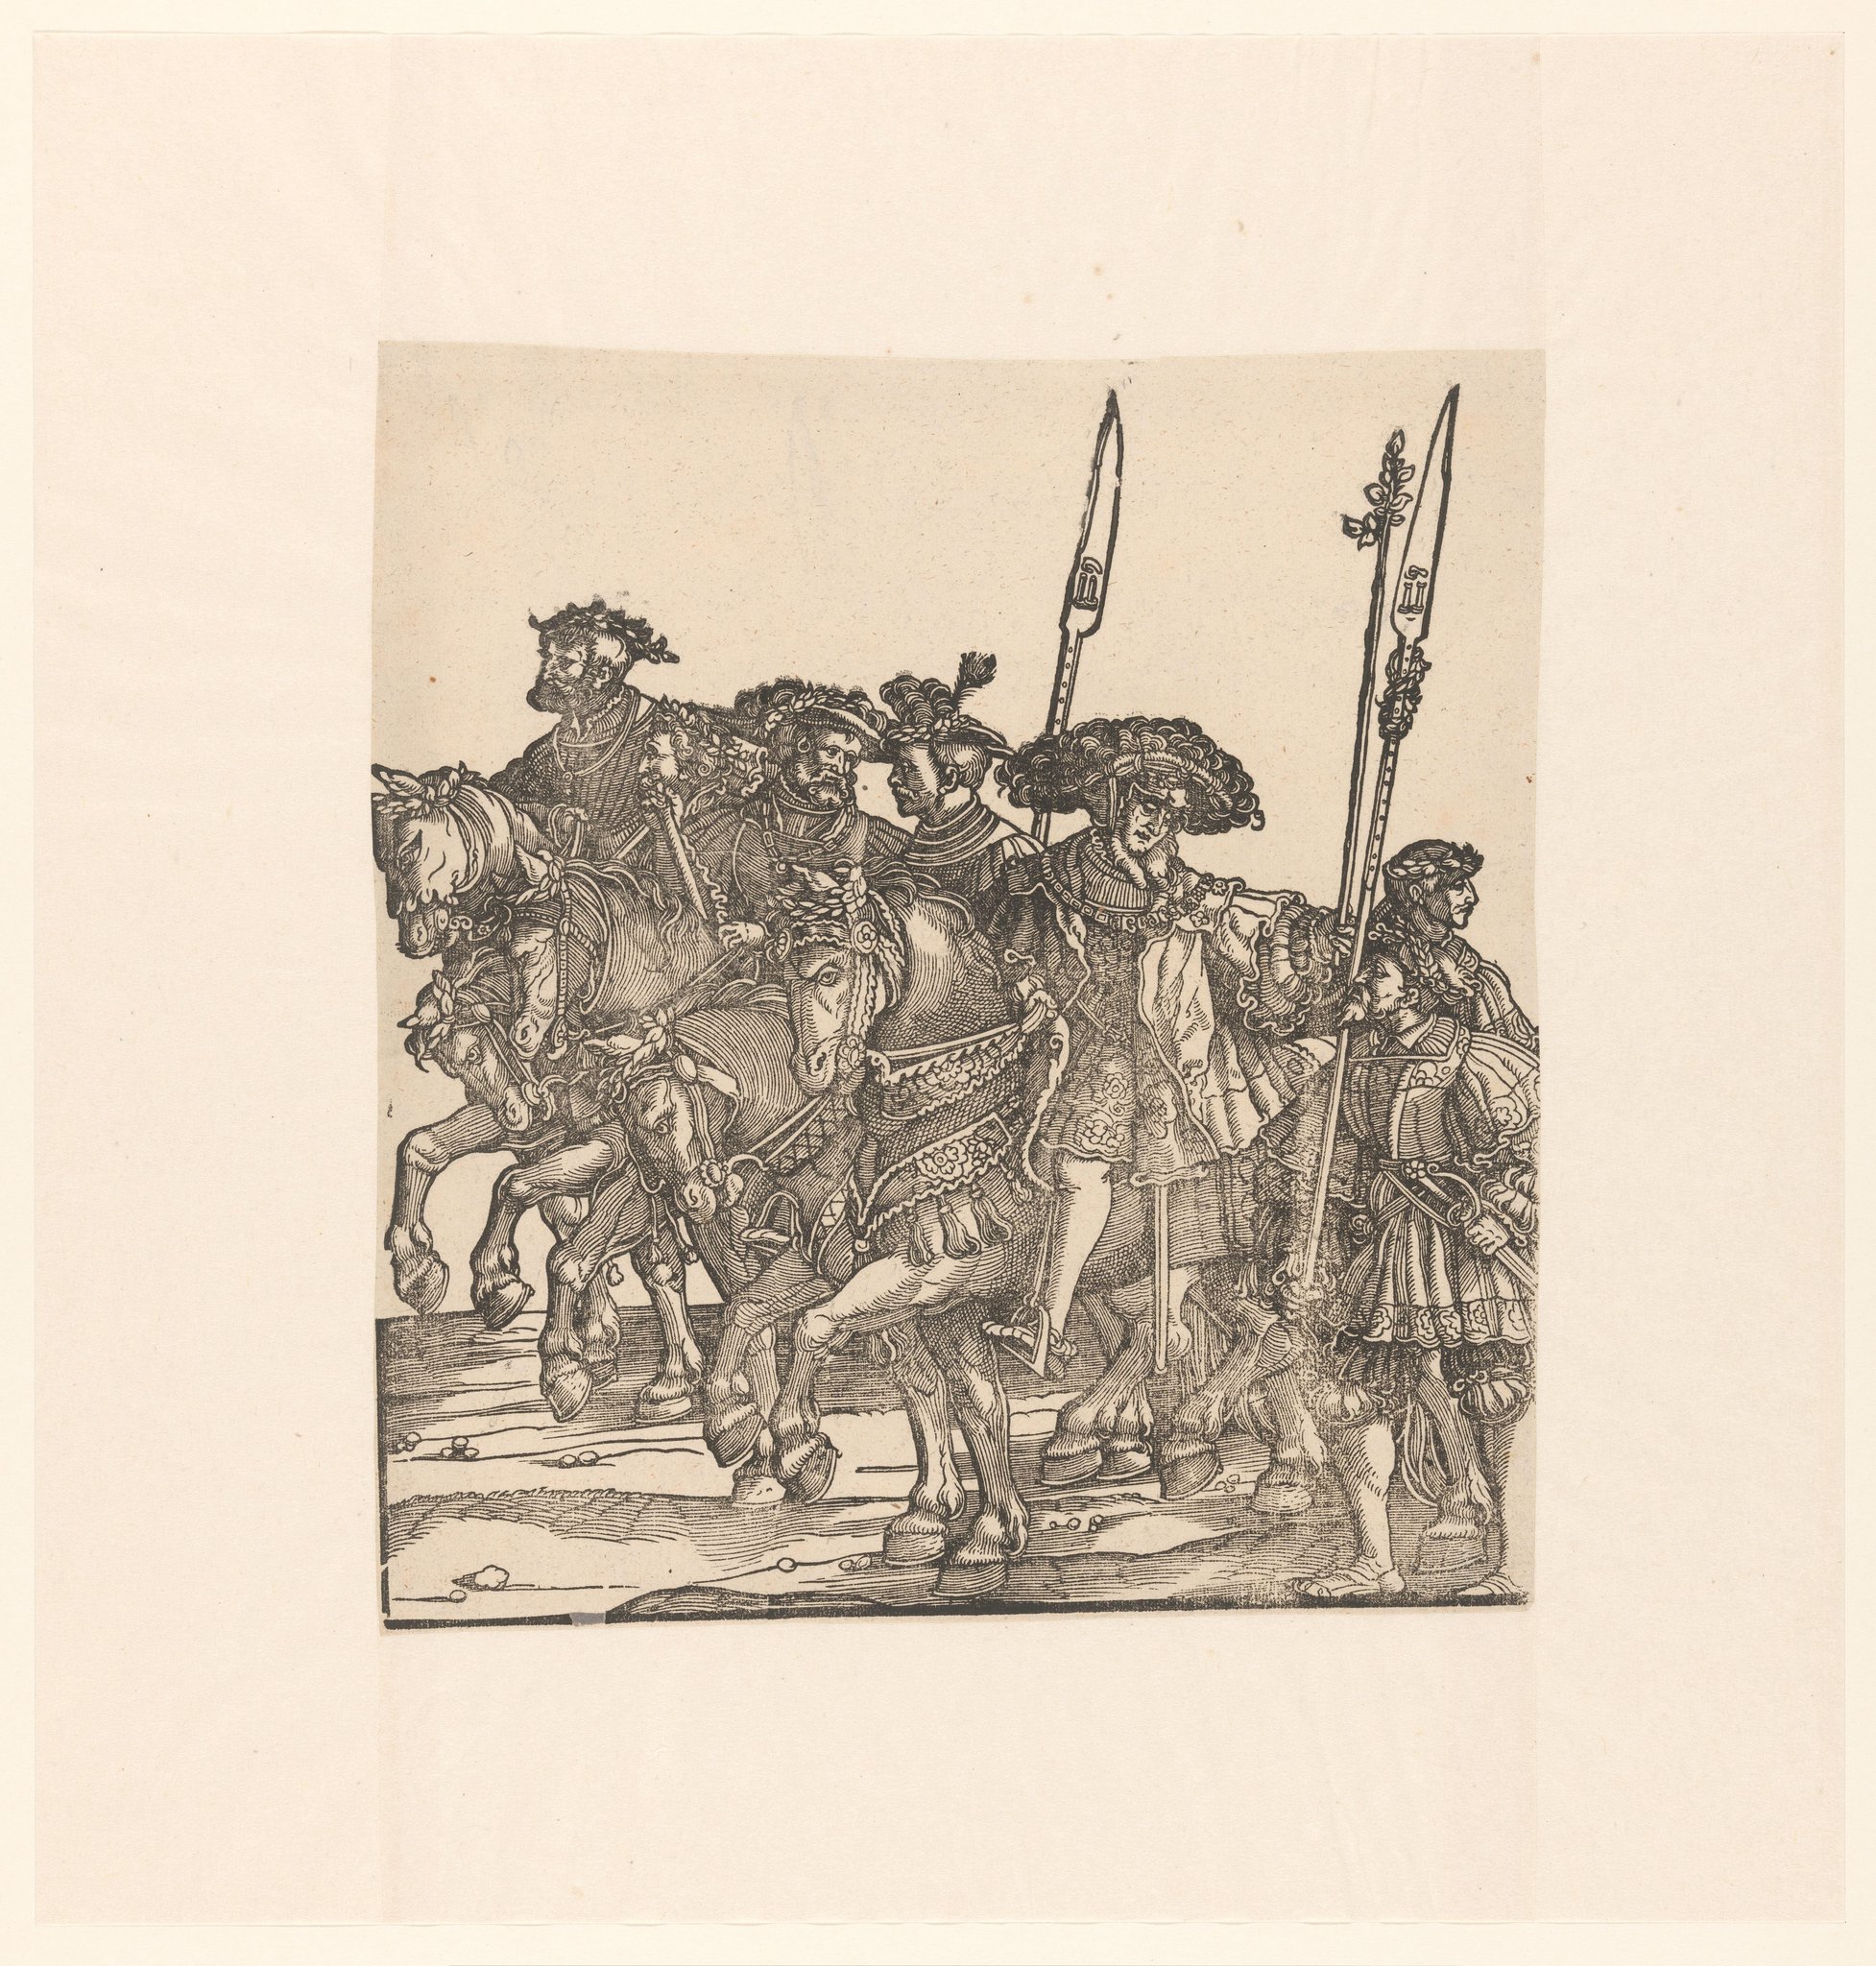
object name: print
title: Ruiters en voetknechten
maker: hans schäufelein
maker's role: print maker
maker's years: 1480-1540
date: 1537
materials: paper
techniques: woodcut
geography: germany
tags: charles v (holy roman emperor and king of spain), chariot, triumphal car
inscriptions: collector's mark: Lugt 2228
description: Serie van 9 houtsneden van de triomfwagen van keizer Karel V die aan elkaar tot een doorlopend fries gemonteerd kunnen worden. De teksten boven de voorstellingen ontbreken in deze druk. Uitgave van deze tweede staat van de blokken is volgens German Hollstein (dl. XLII, p. 126) te dateren ca. 1537-1551. De watermerken van deze afdrukken wijzen op een latere datering ca. 1580-1616. De prenten worden hier beschreven naar de volgorde in Bartsch, een andere volgende dan in Hollstein en Geisberg staat, namelijk met de platen Hollstein German 51 en 52 (de plaat met het impressum) niet als de derde en vierde platen maar als achtste en negende (voorlaatste en laatste).